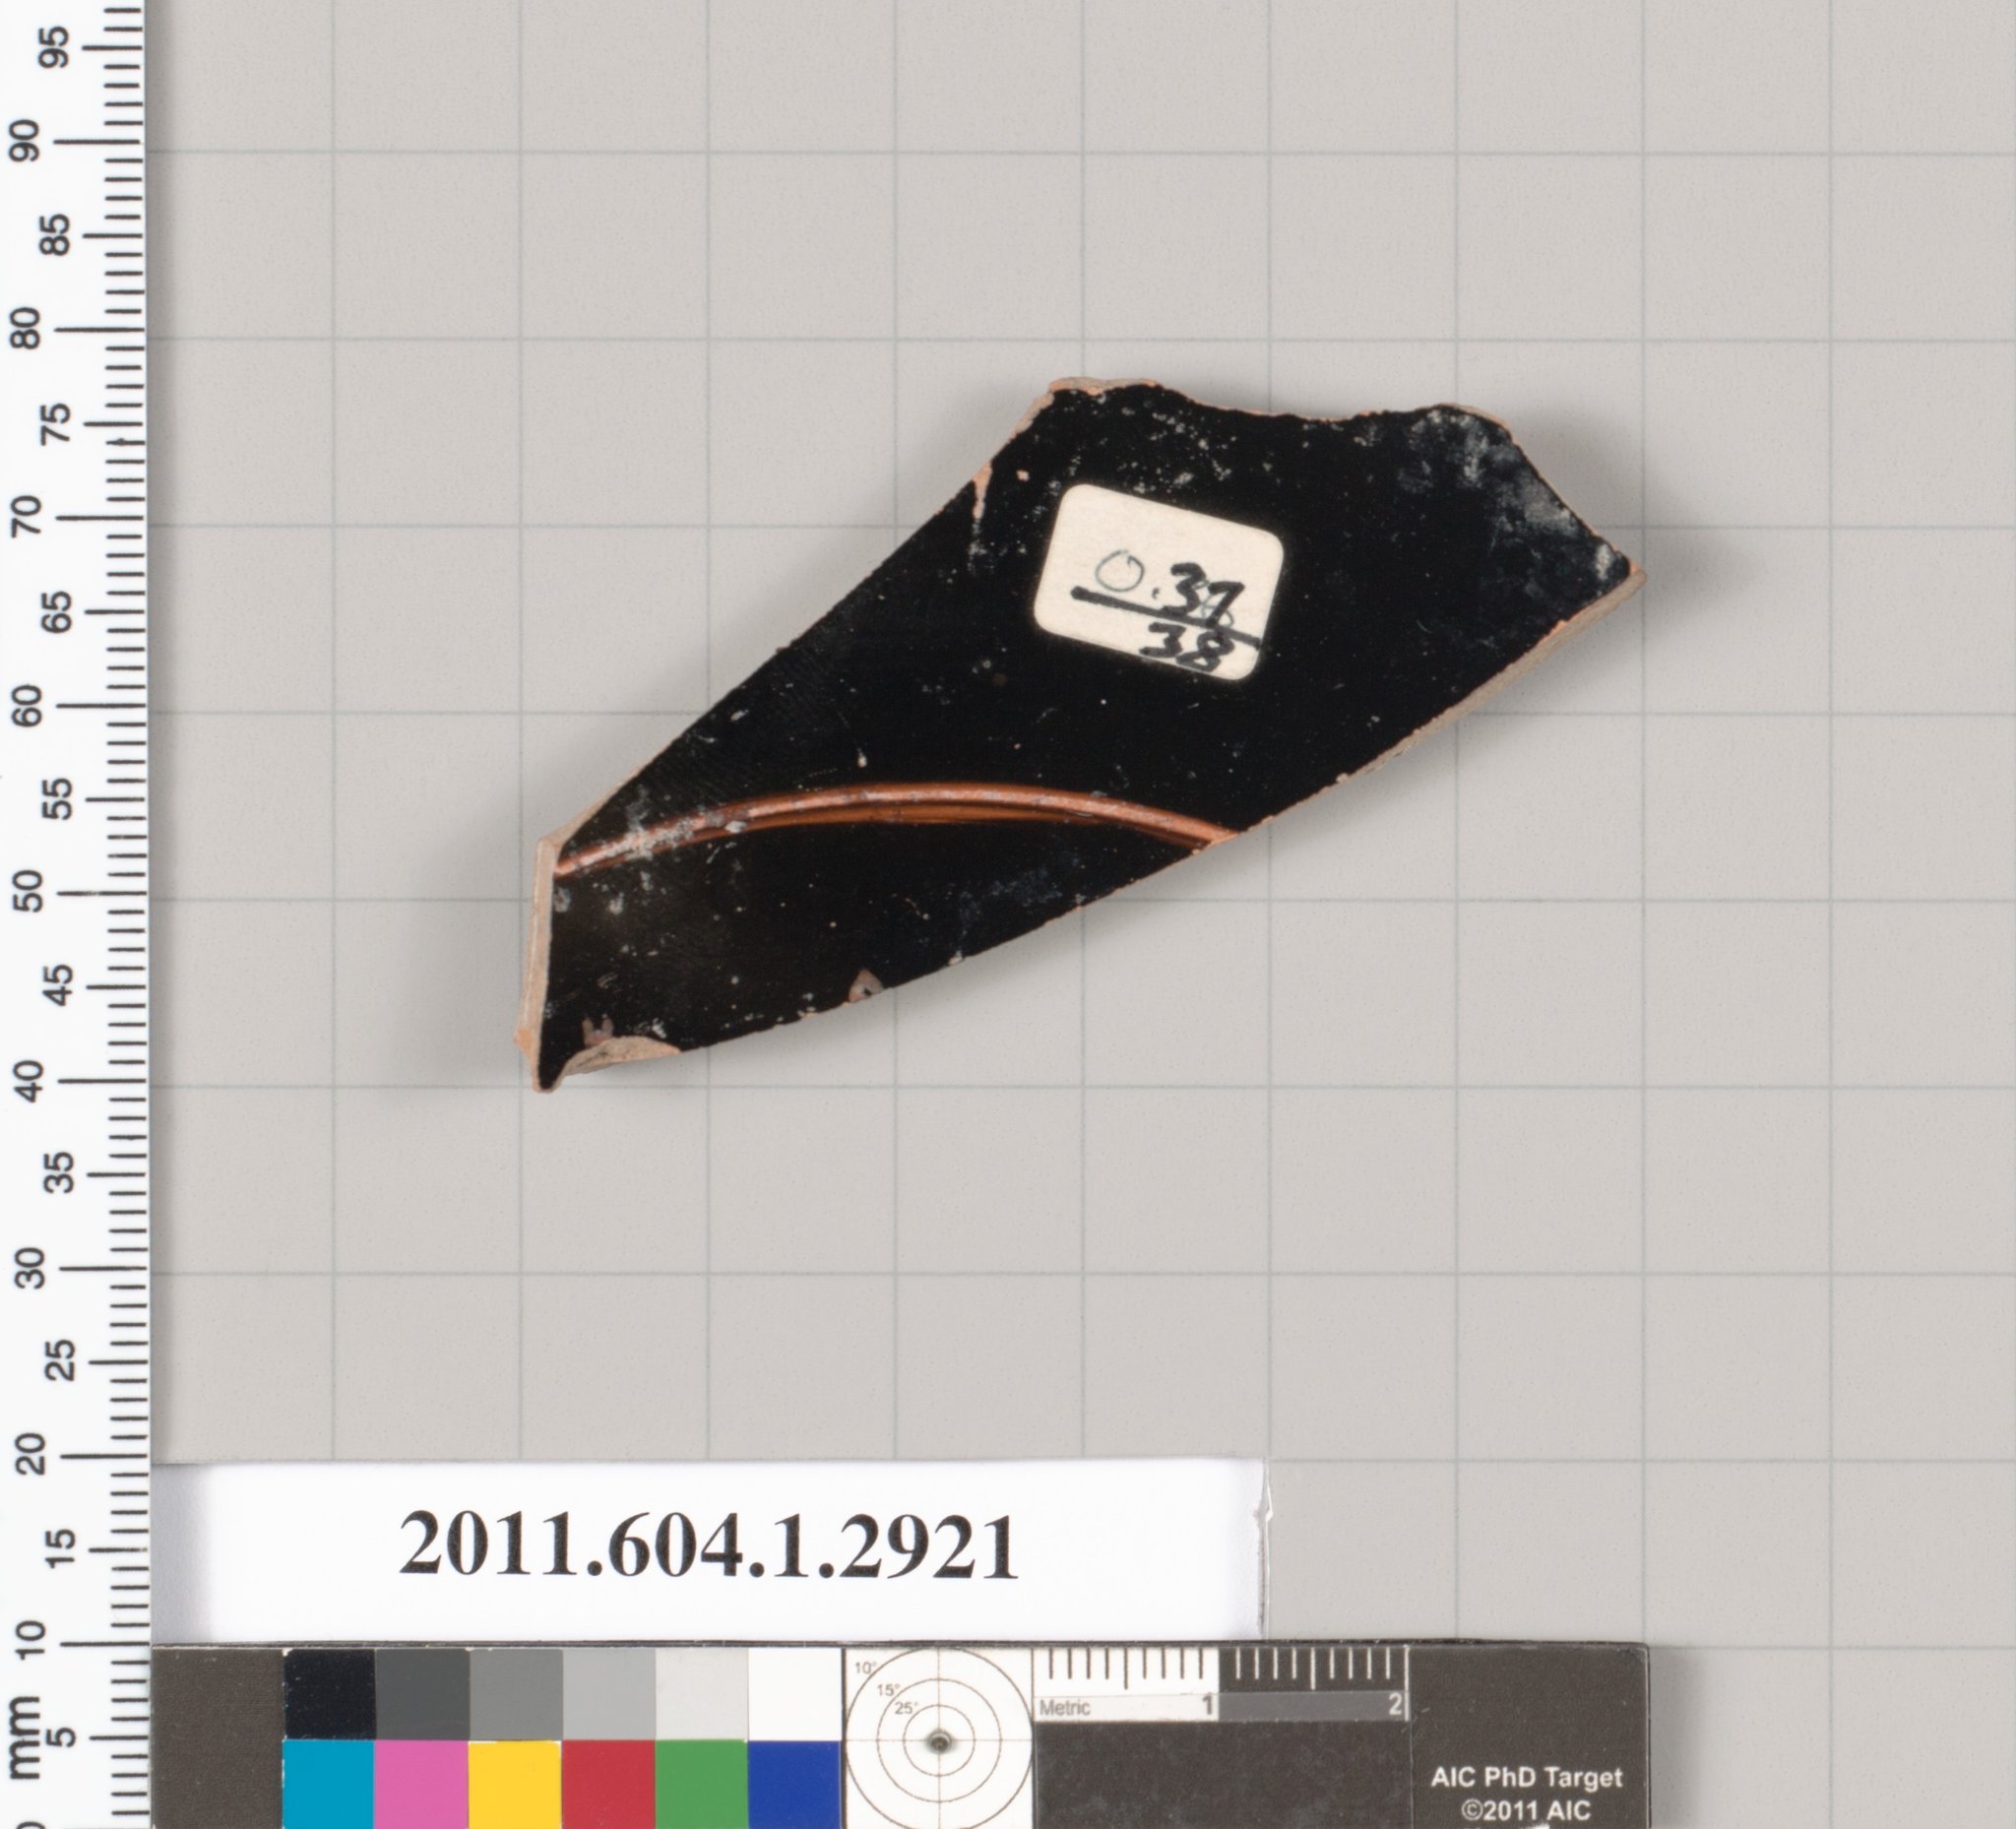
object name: kylix fragment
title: Terracotta fragment of a kylix (drinking cup)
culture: greek, attic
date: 600-401 BCE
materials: terracotta